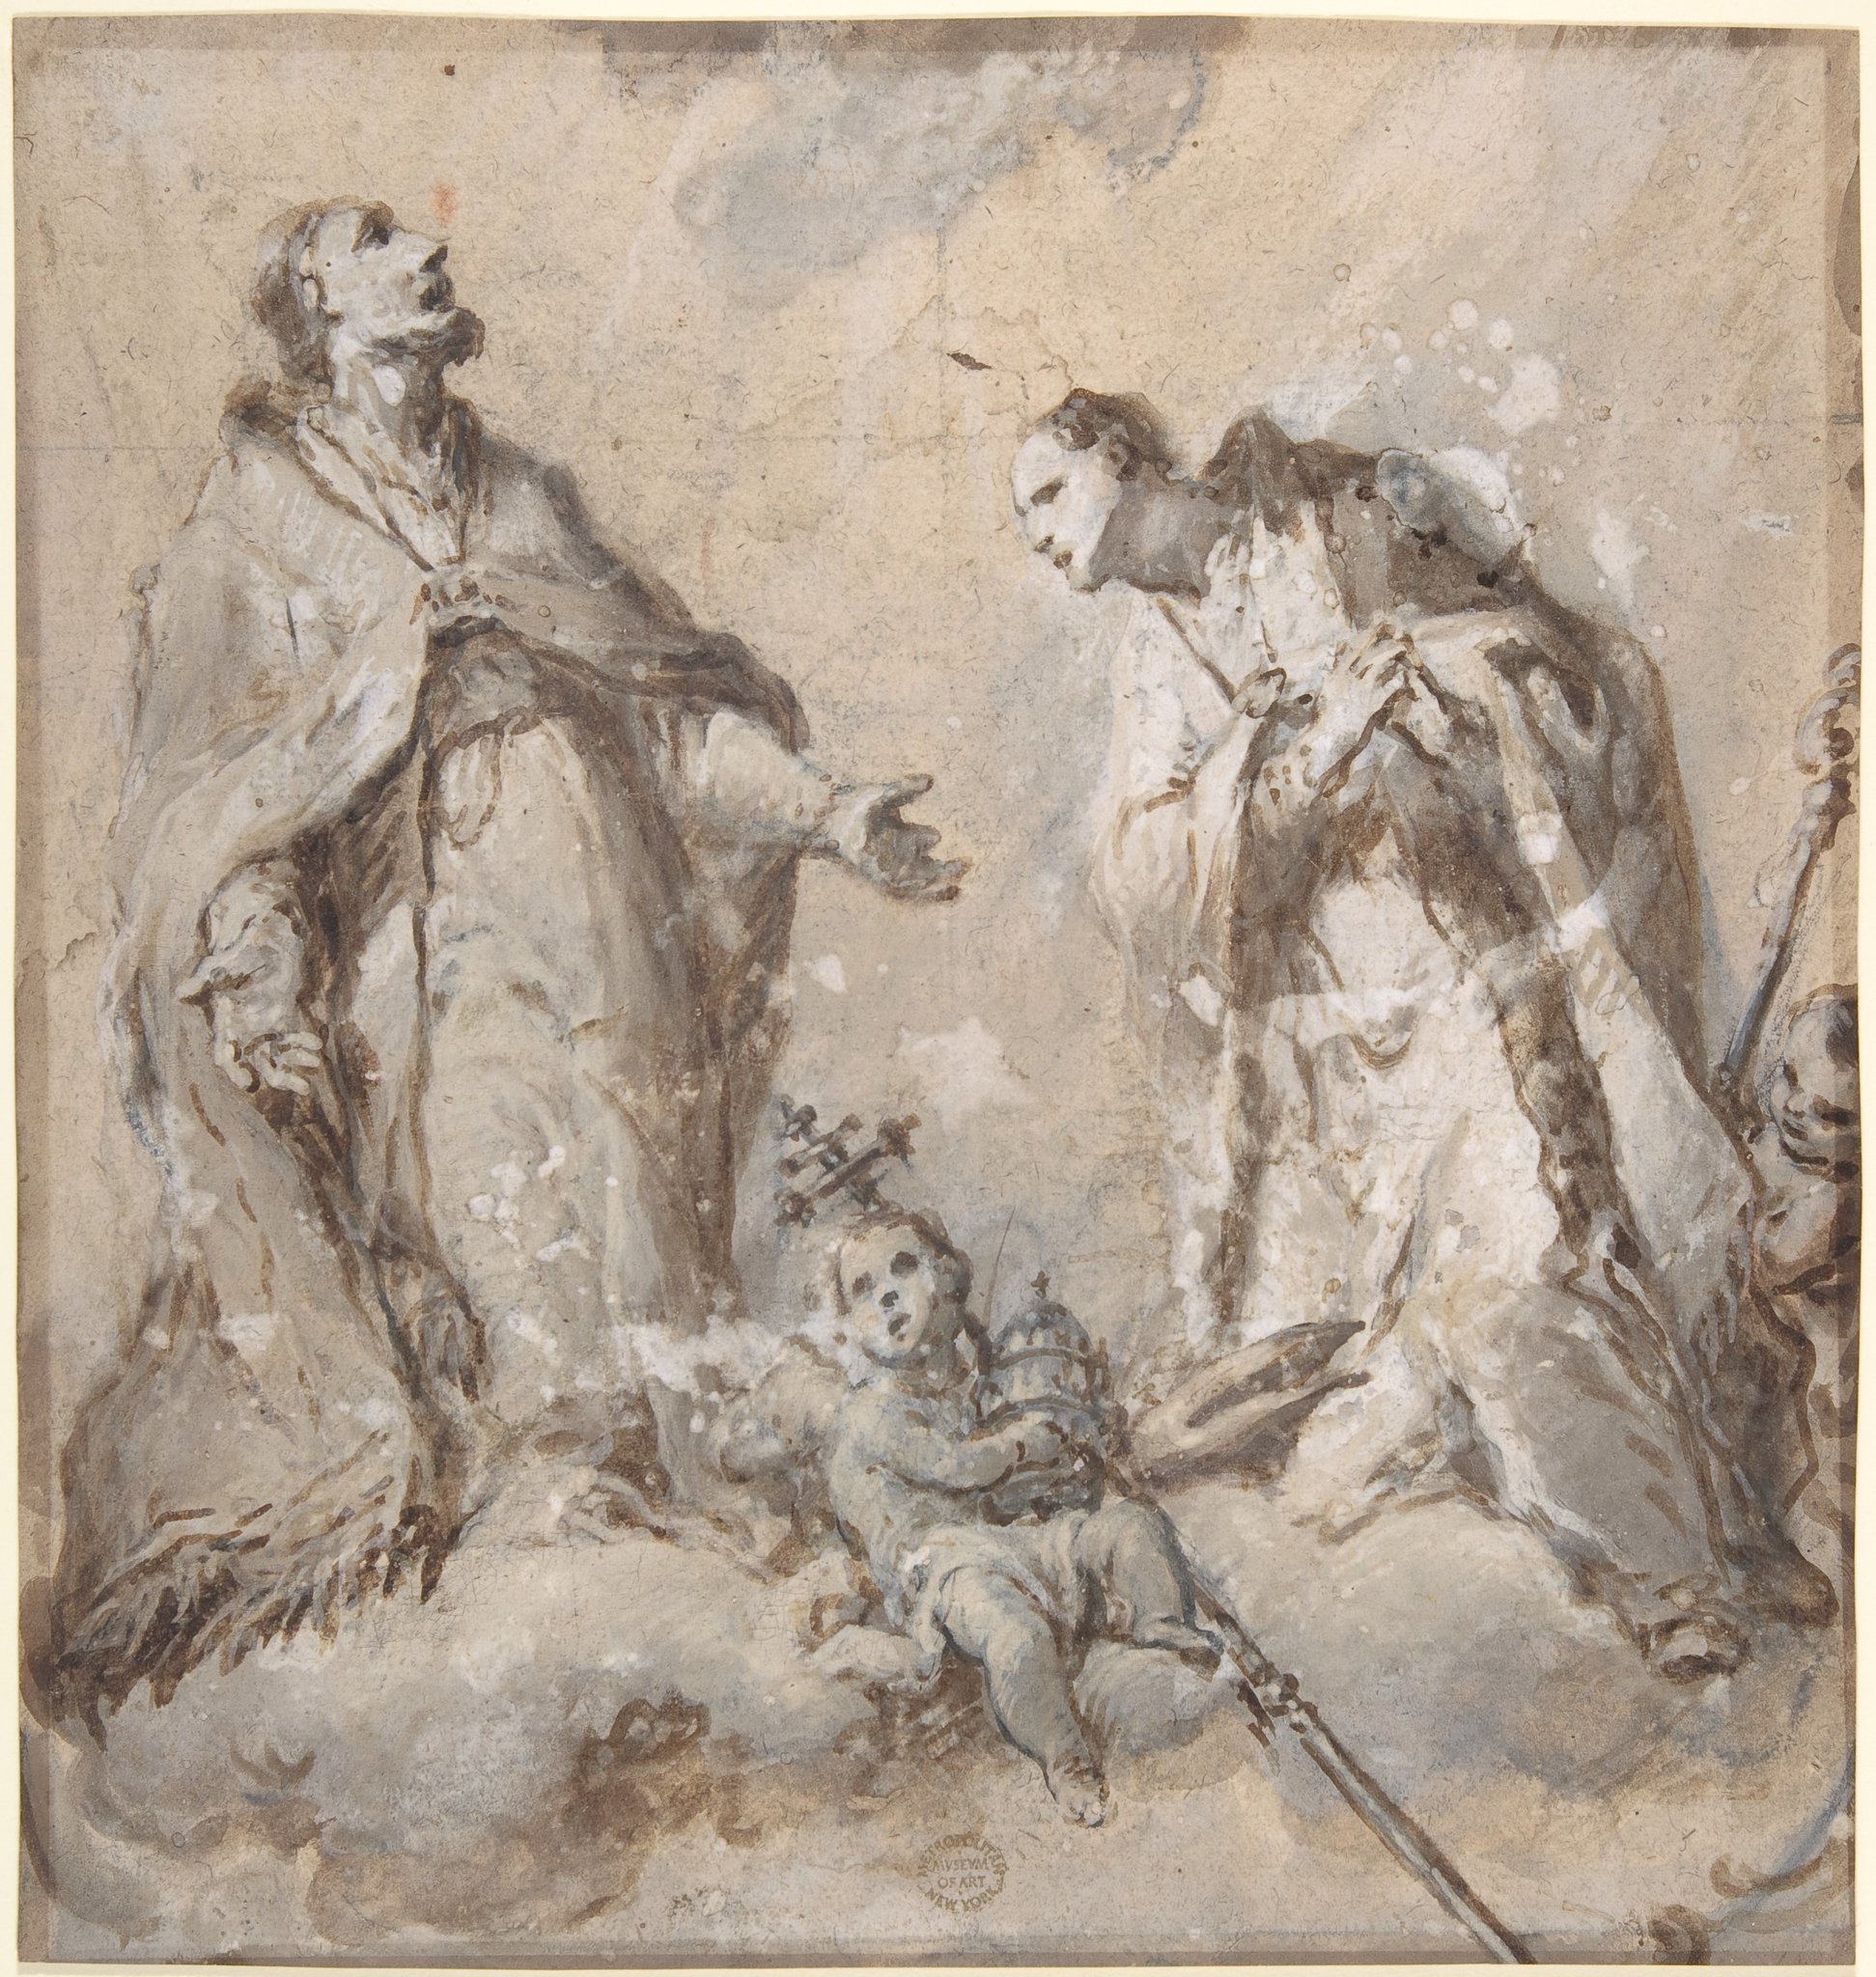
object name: drawing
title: Two Saints (Pope and Bishop?)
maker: anonymous, italian, roman-bolognese, 17th century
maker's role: artist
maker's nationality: italian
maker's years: 1600-1700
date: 1601-1700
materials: chalk, gouache, ink, paper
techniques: brush, highlighting, drawing, transfer, wash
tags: children,saints